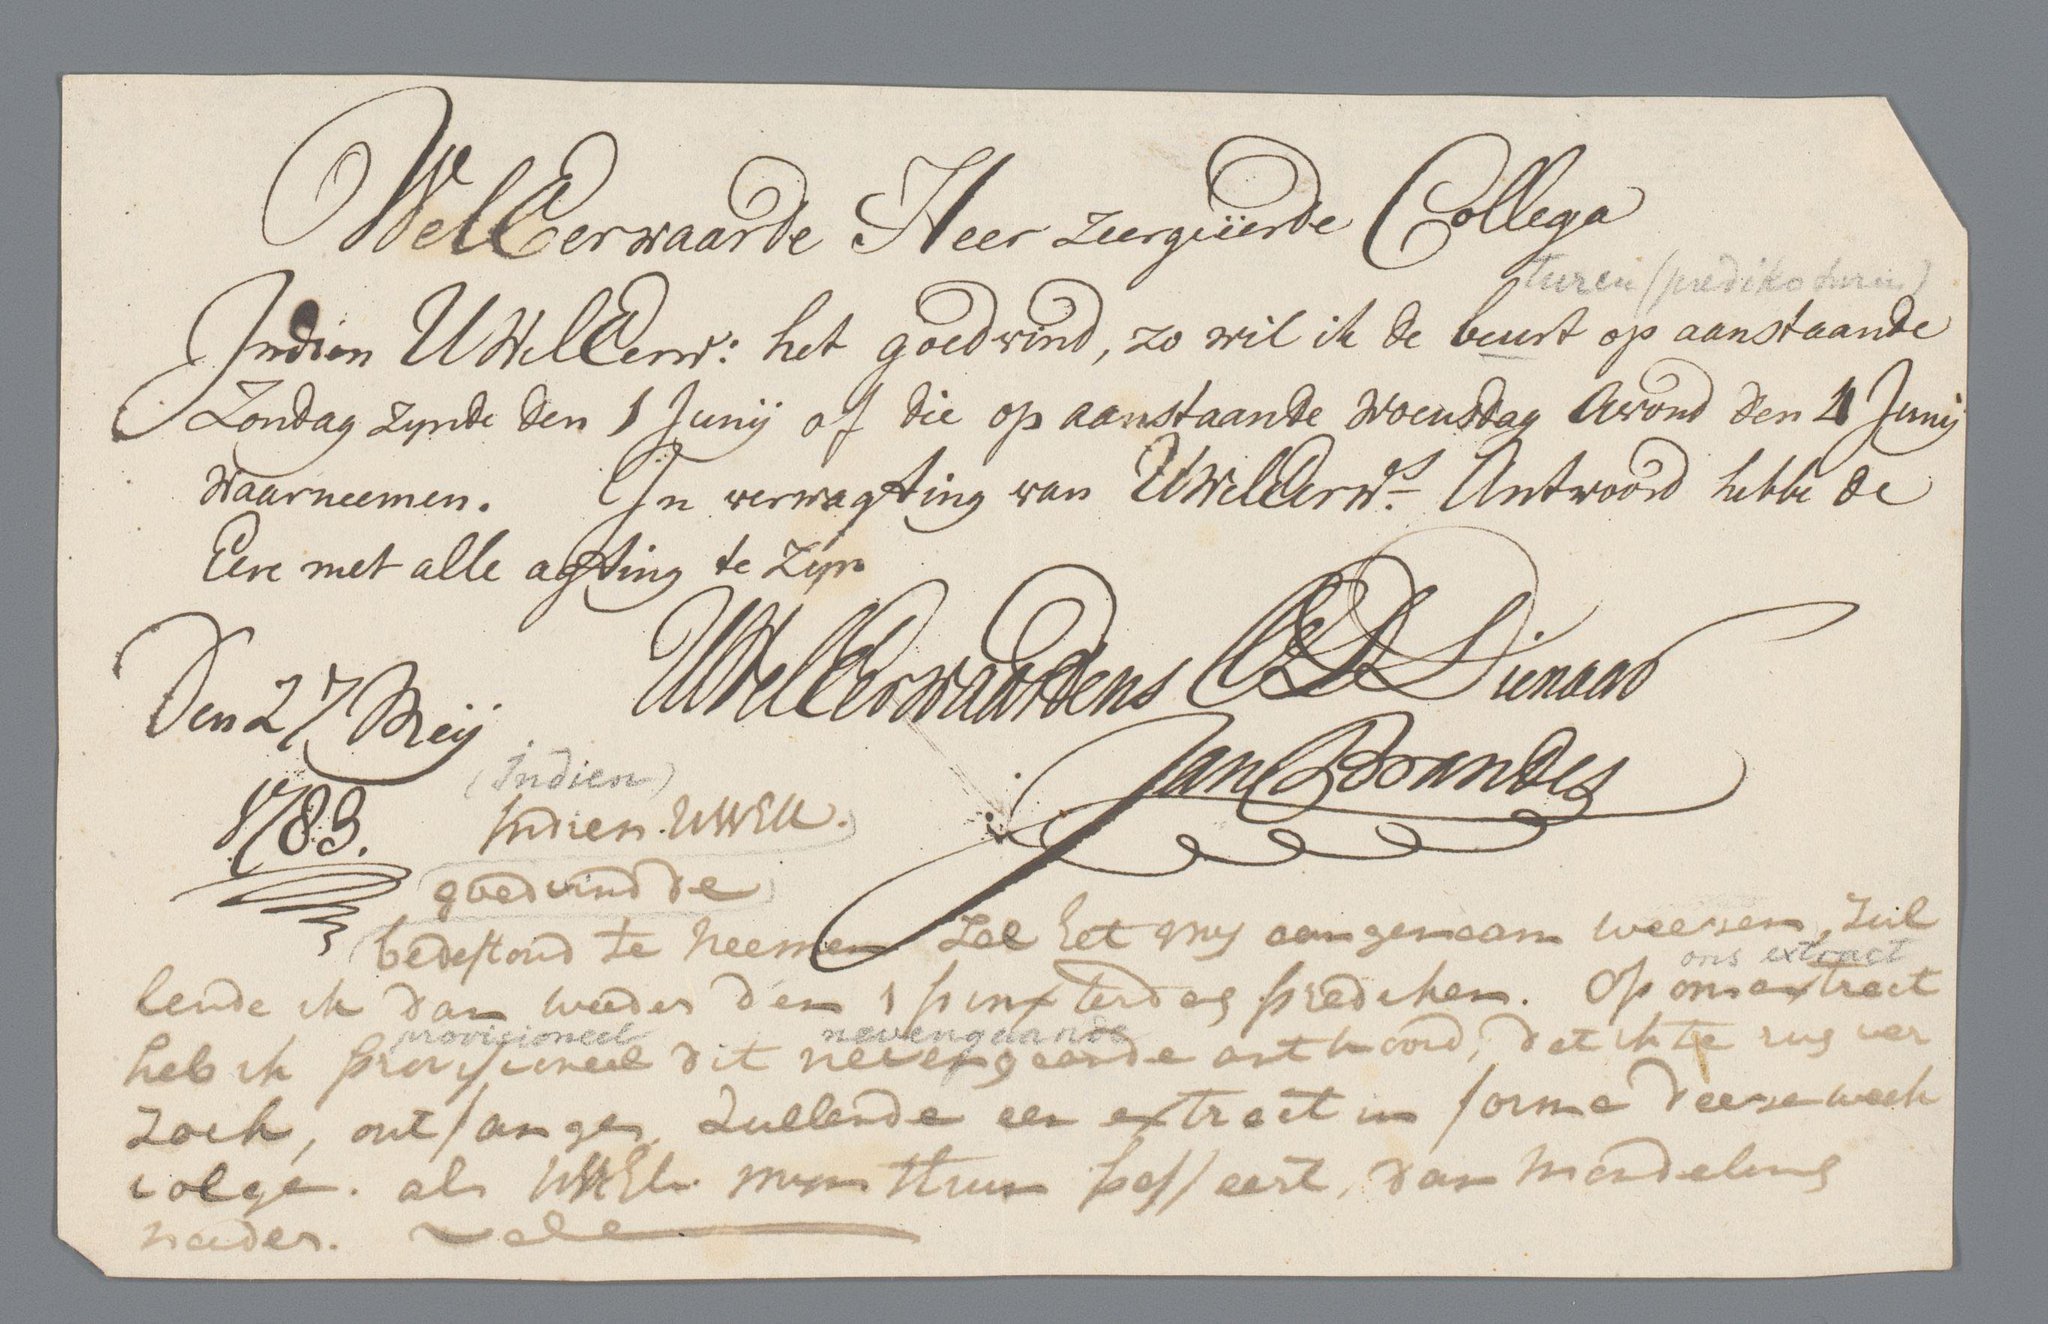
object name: document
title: Brief van ds. Hooyman aan Jan Brandes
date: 1783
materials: ink, paper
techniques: pen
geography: batavia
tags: bodegraven, draughtsman, jan brandes, batavia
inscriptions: date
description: Briefje van de predikant Johannes Hooyman van 27 mei 1783 aan Jan Brandes over het omruilen van preekbeurten, met onderaan het antwoord van Brandes. Onderdeel van een groep papieren van Jan Brandes uit zijn tijd als predikant bij de lutherse kerk te Batavia 1779-1785.